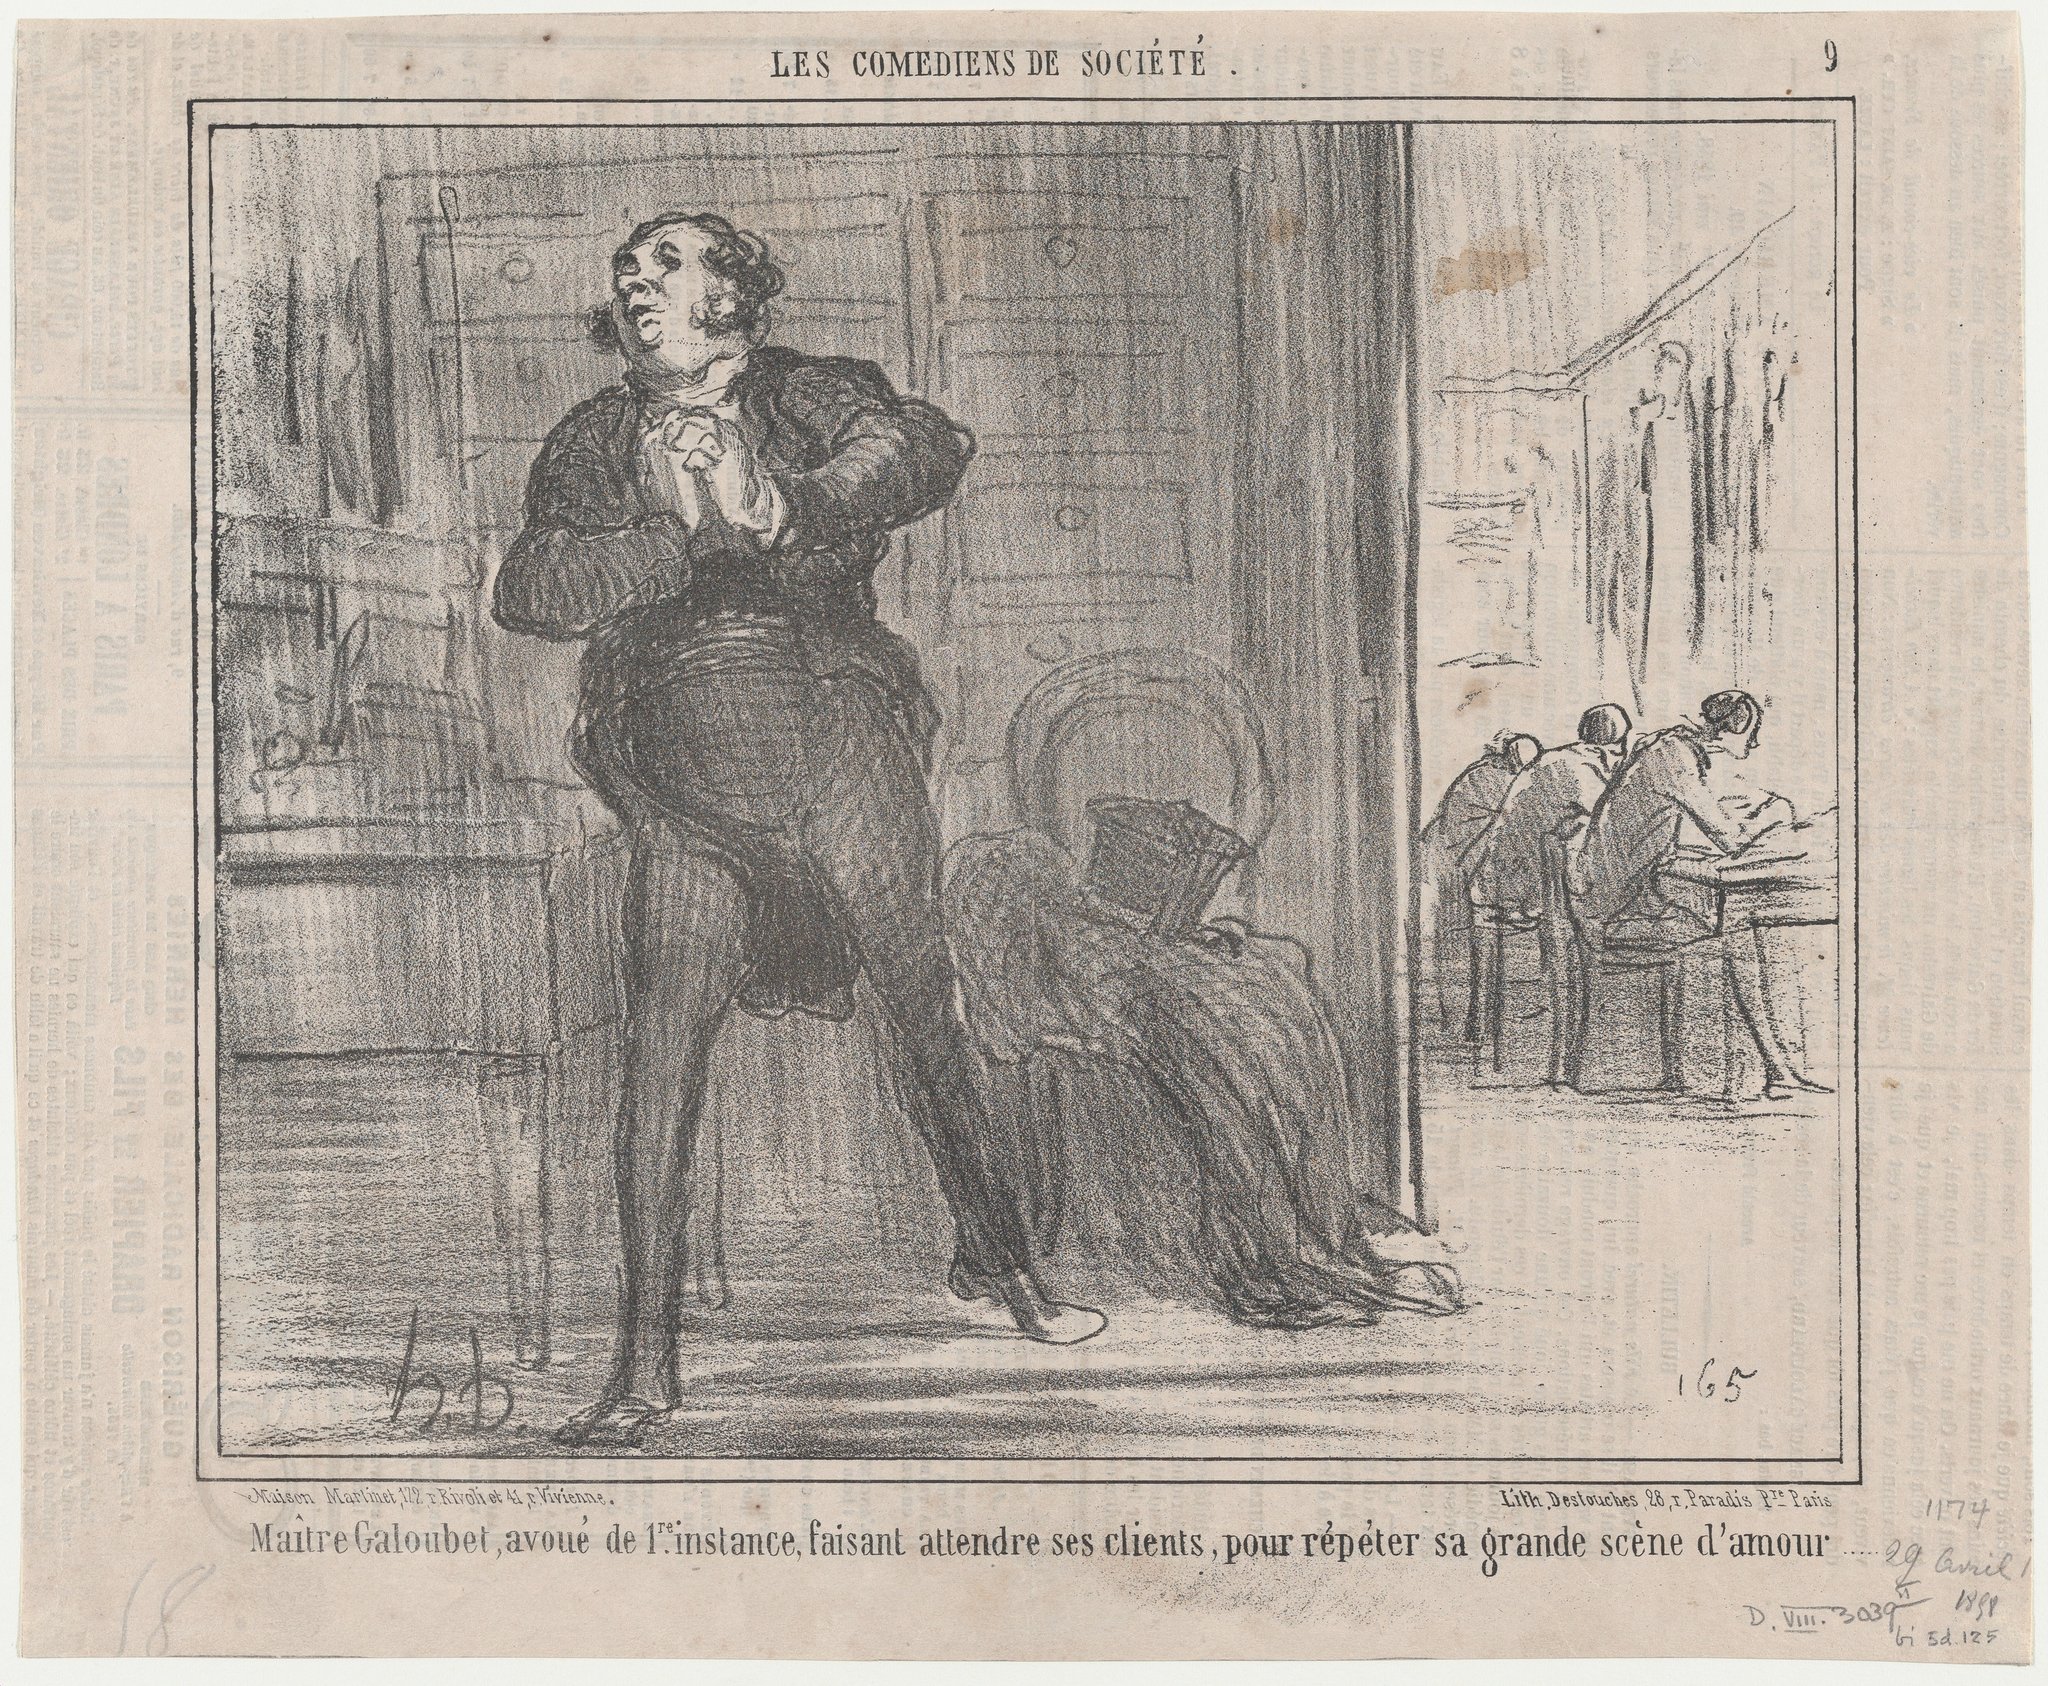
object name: print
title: Maître Galoubet, avoué de 1re. instance, faisant attendre ses clients, pour répéter sa grande scène d'amour..., from Les Comédiens de Société, published in Le Charivari, April 29, 1858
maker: honoré daumier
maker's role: artist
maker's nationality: french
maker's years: 1808-1879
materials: paper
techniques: lithograph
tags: men